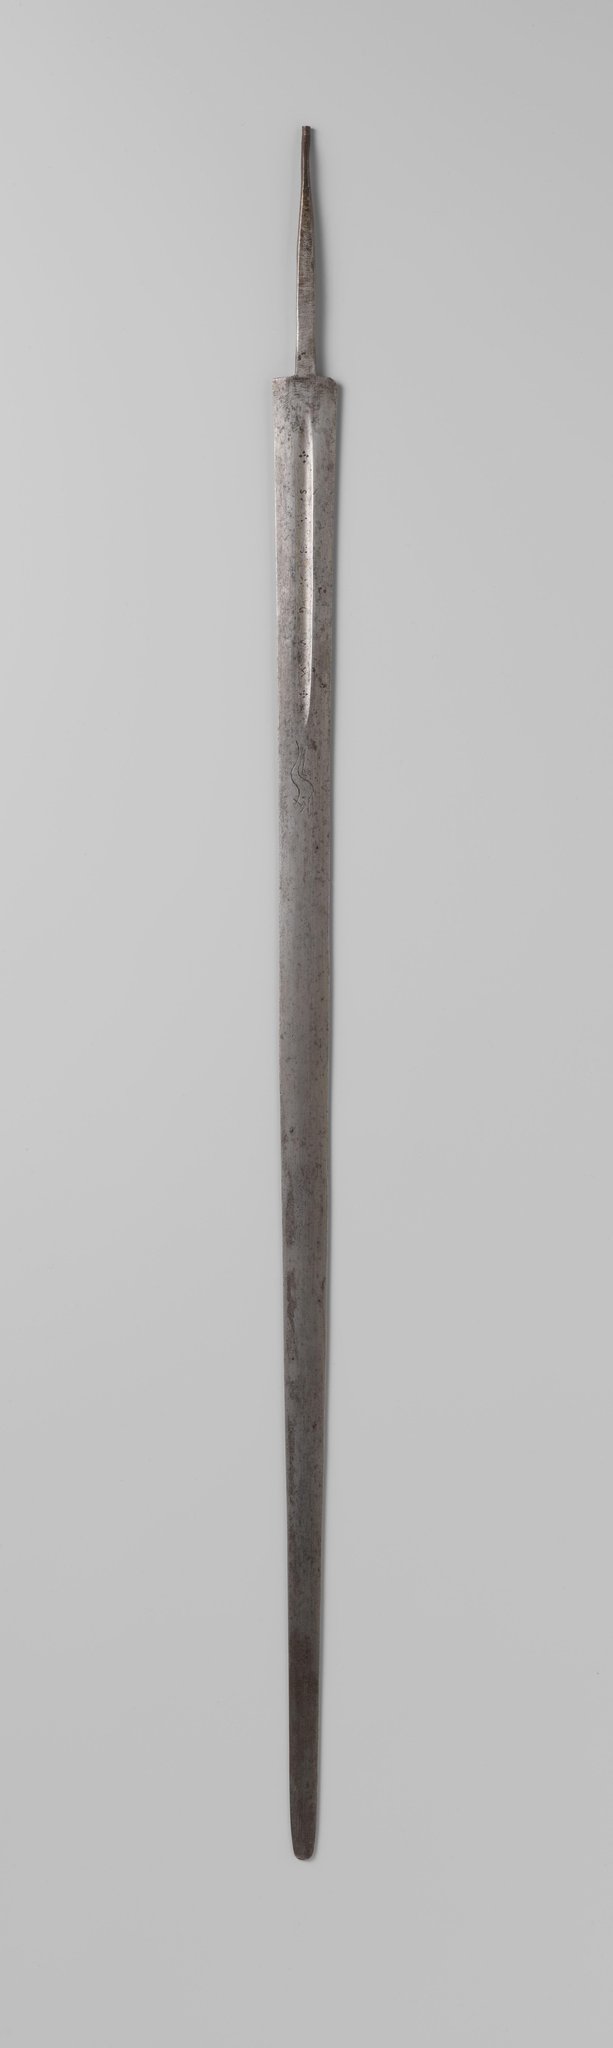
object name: knife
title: Kling voor ruiterdegen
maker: Anonymous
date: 1550-1900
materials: iron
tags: netherlands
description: Kling voor ruiterdegen met opschrift: SAHAGUM en afbeelding van een lopend dier.